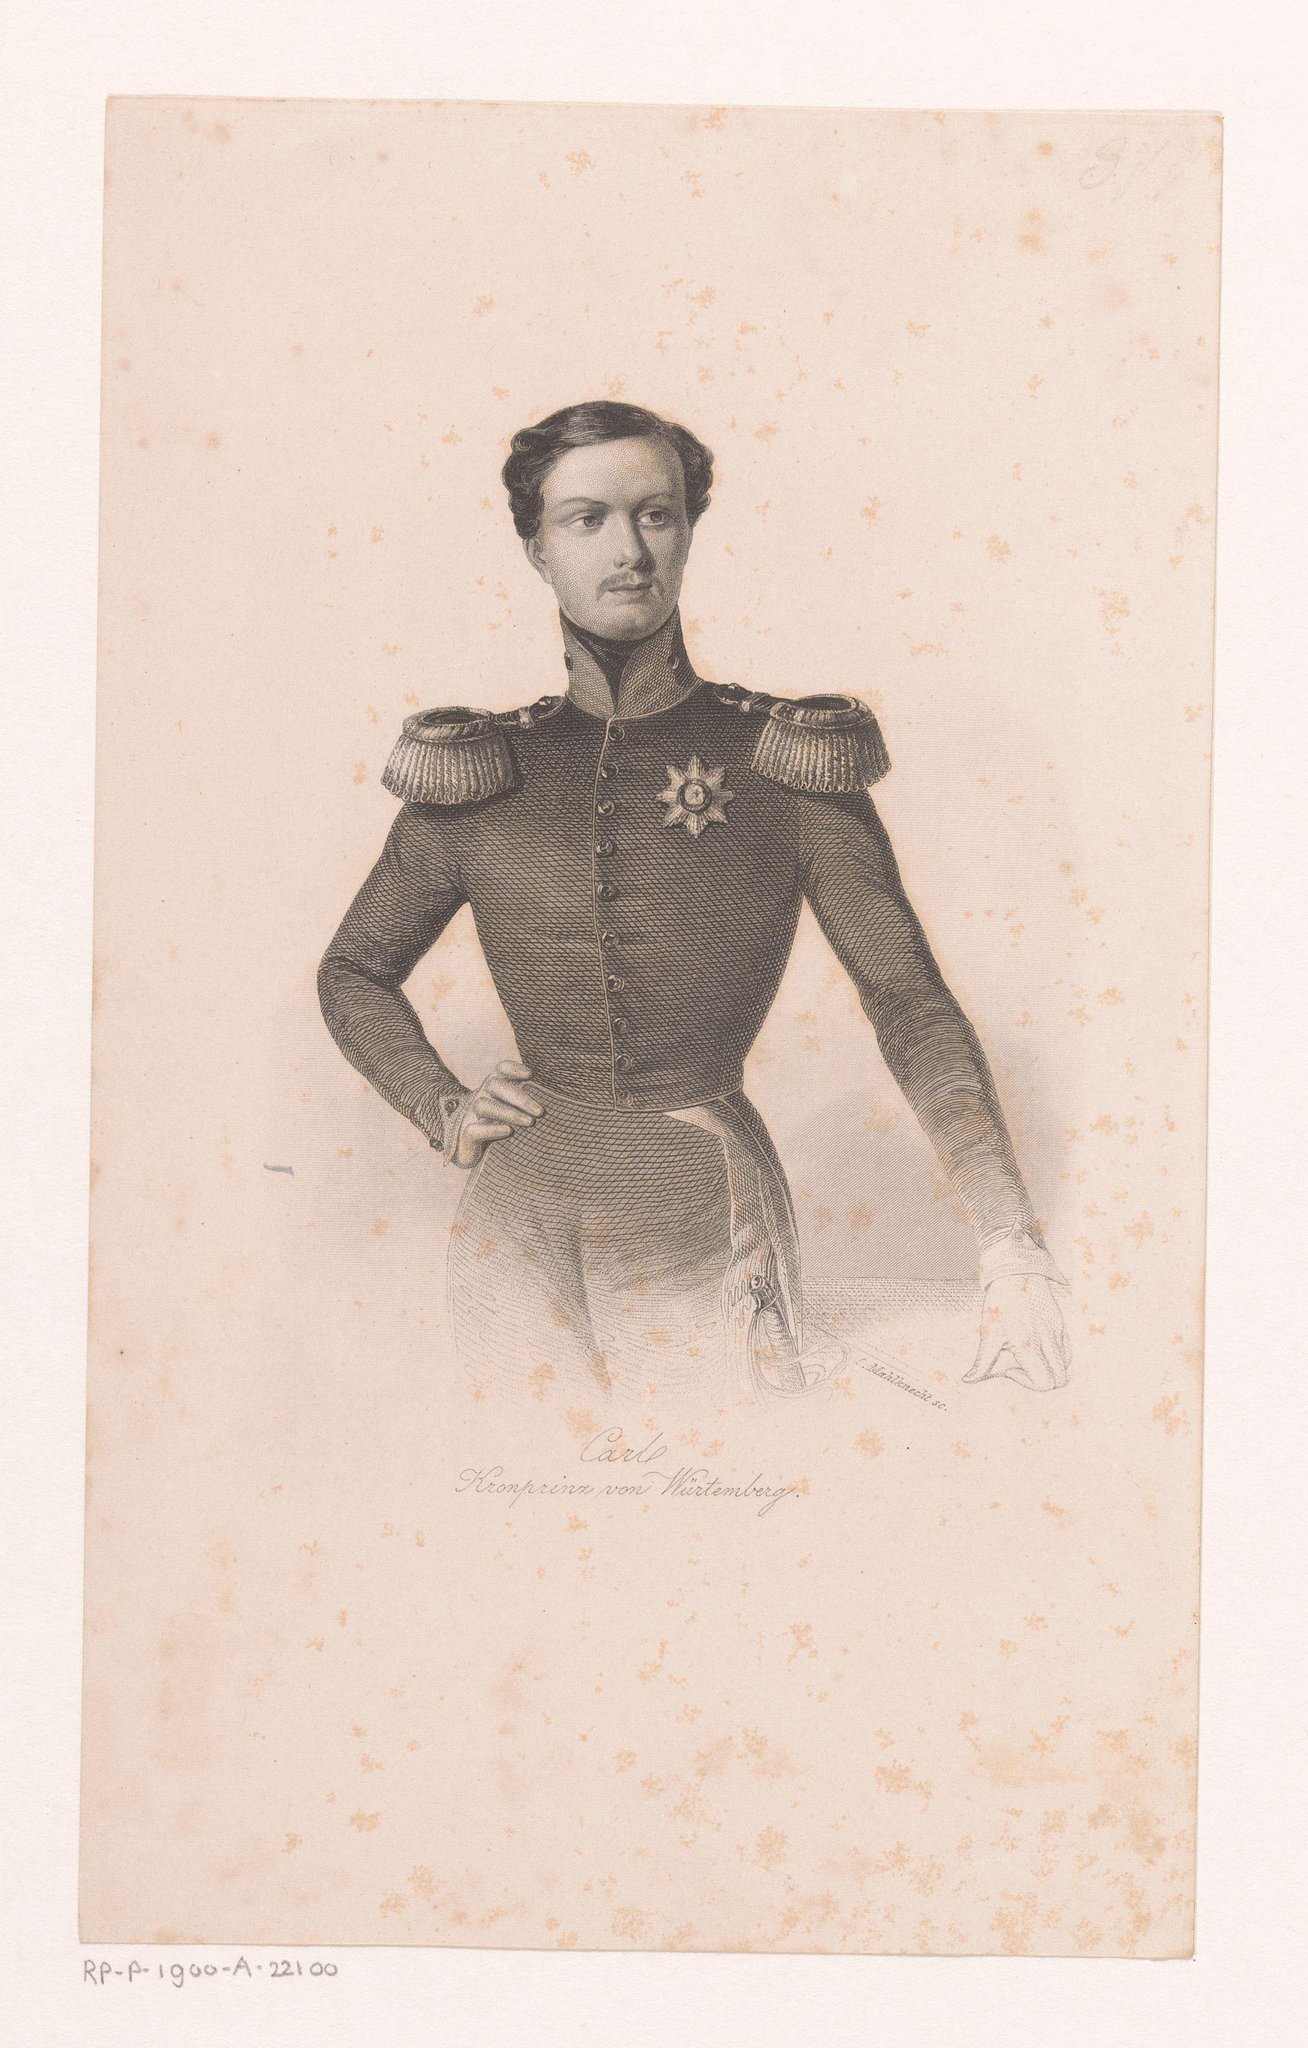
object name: print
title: Portret van Karel I, kroonprins van Würtemberg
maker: karl mahlknecht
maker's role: print maker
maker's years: 1810-1893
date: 1820-1893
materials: paper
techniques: engraving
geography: vienna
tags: historical persons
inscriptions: collector's mark: Lugt 2228